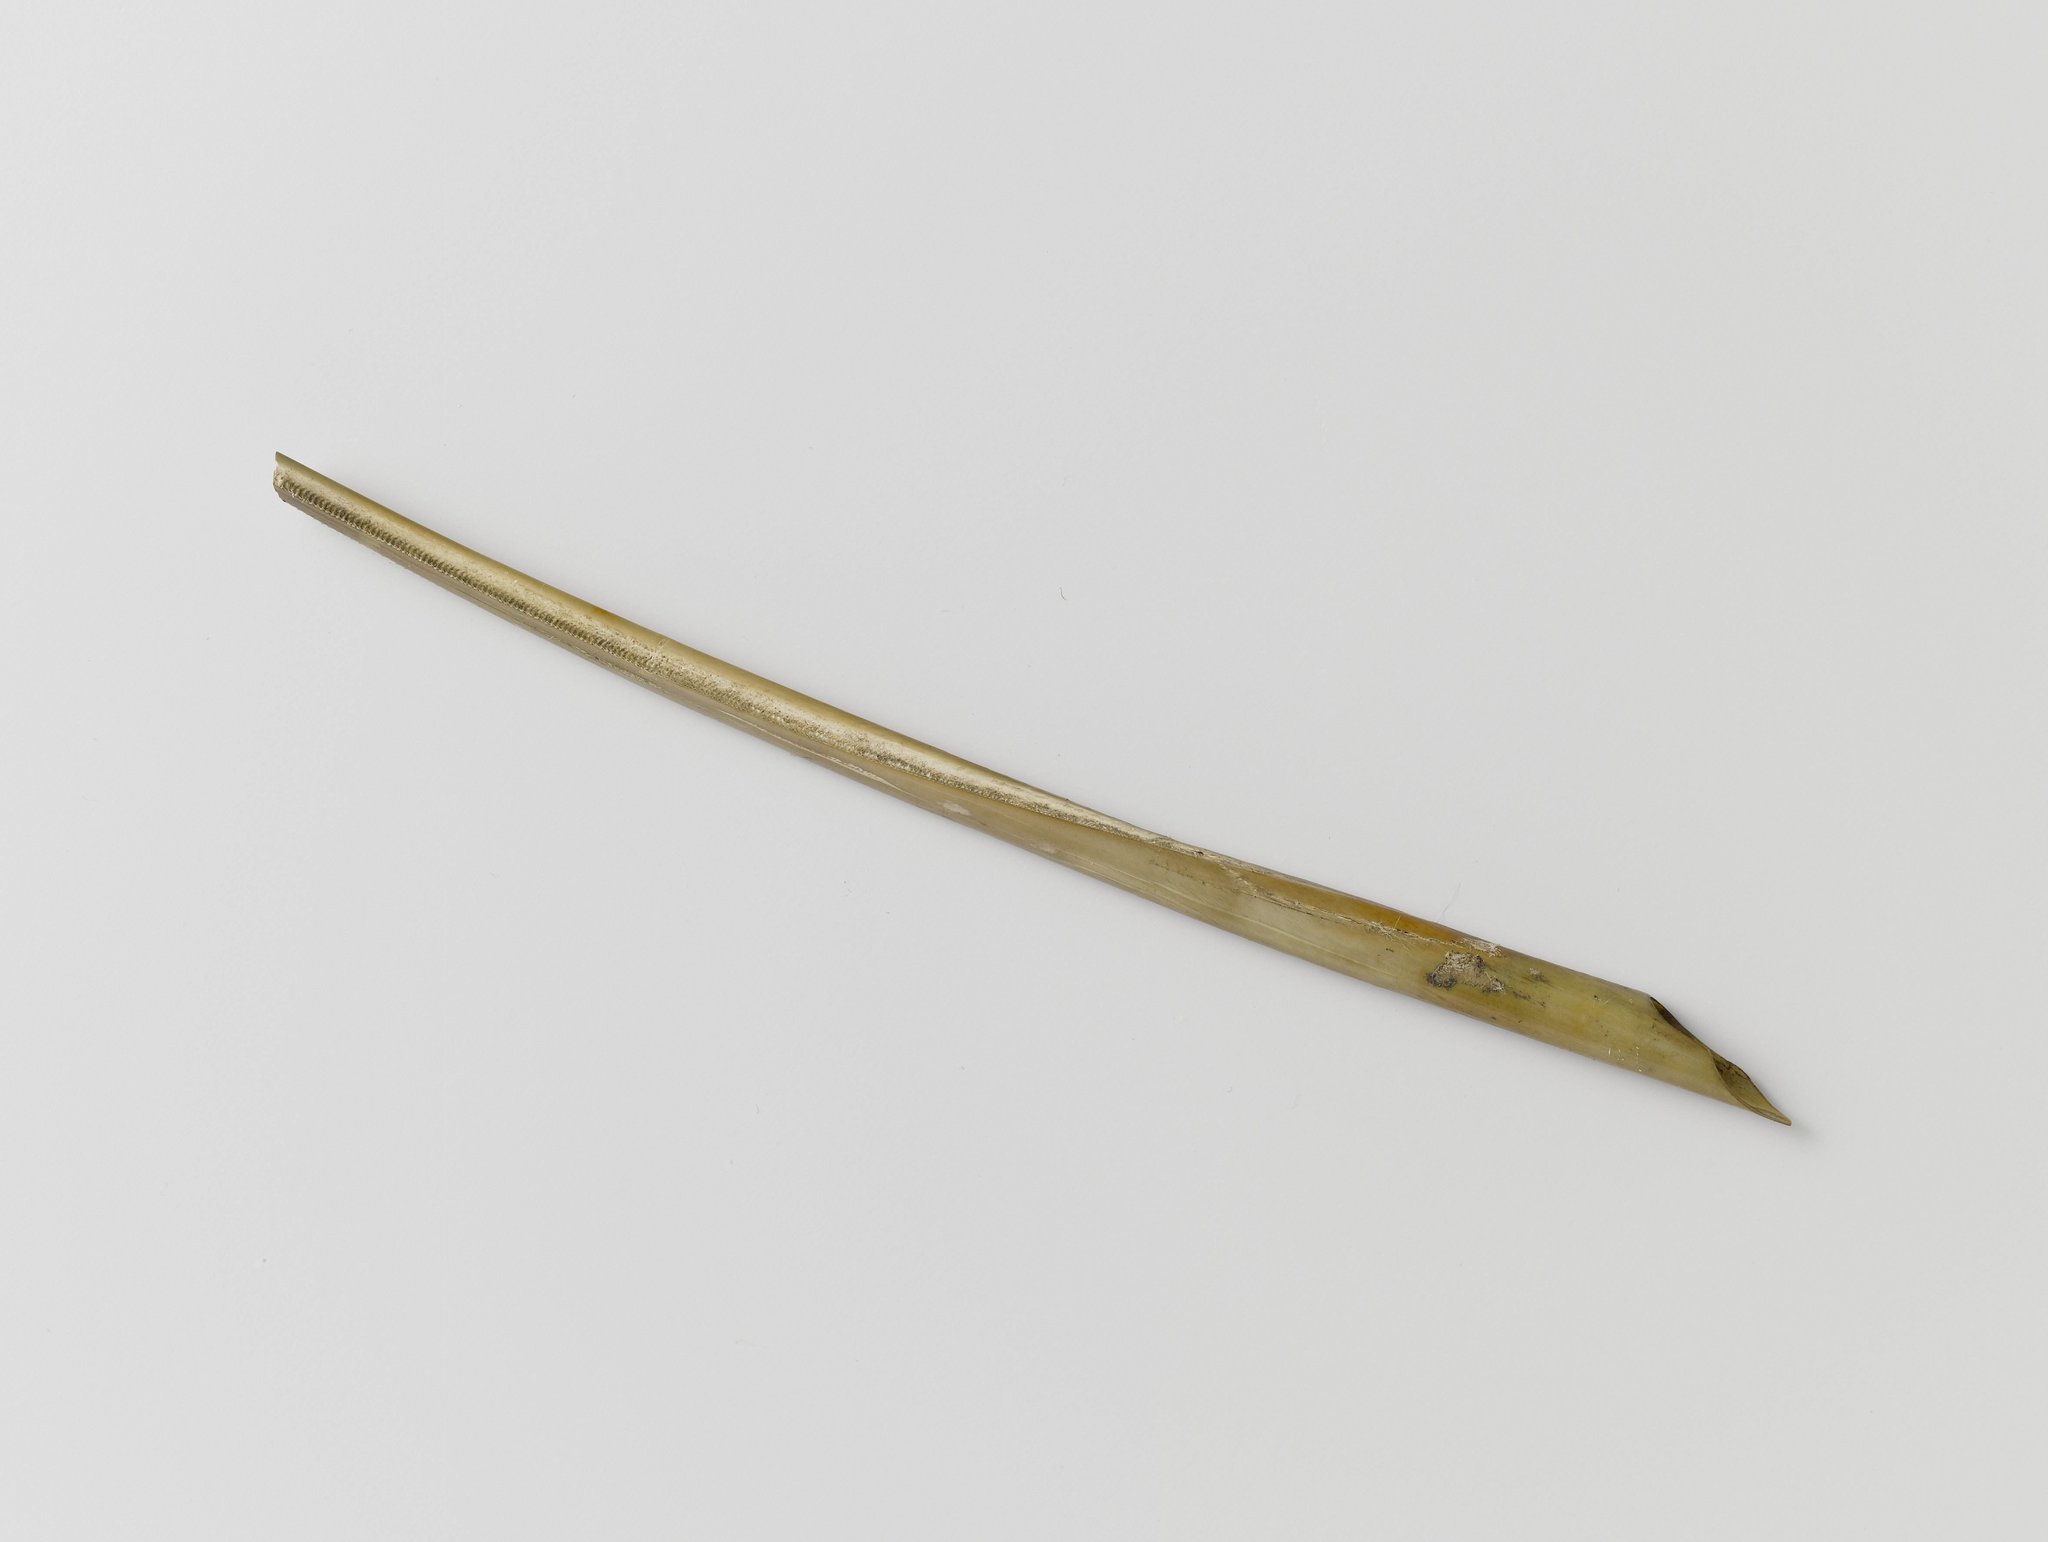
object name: quill pen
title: Navigation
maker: Anonymous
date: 1590-1596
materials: feather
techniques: cutting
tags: willem barendsz., amsterdam, jacob van heemskerck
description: To determine the ship’s position and chart its course, the captain had an entire arsenal of instruments at his disposal. Among the items found on Nova Zembla are an astrolabium catholicum (universal astrolabe), a fragment of a copper sounding line, a cross staff, a sextant and a chart compass.